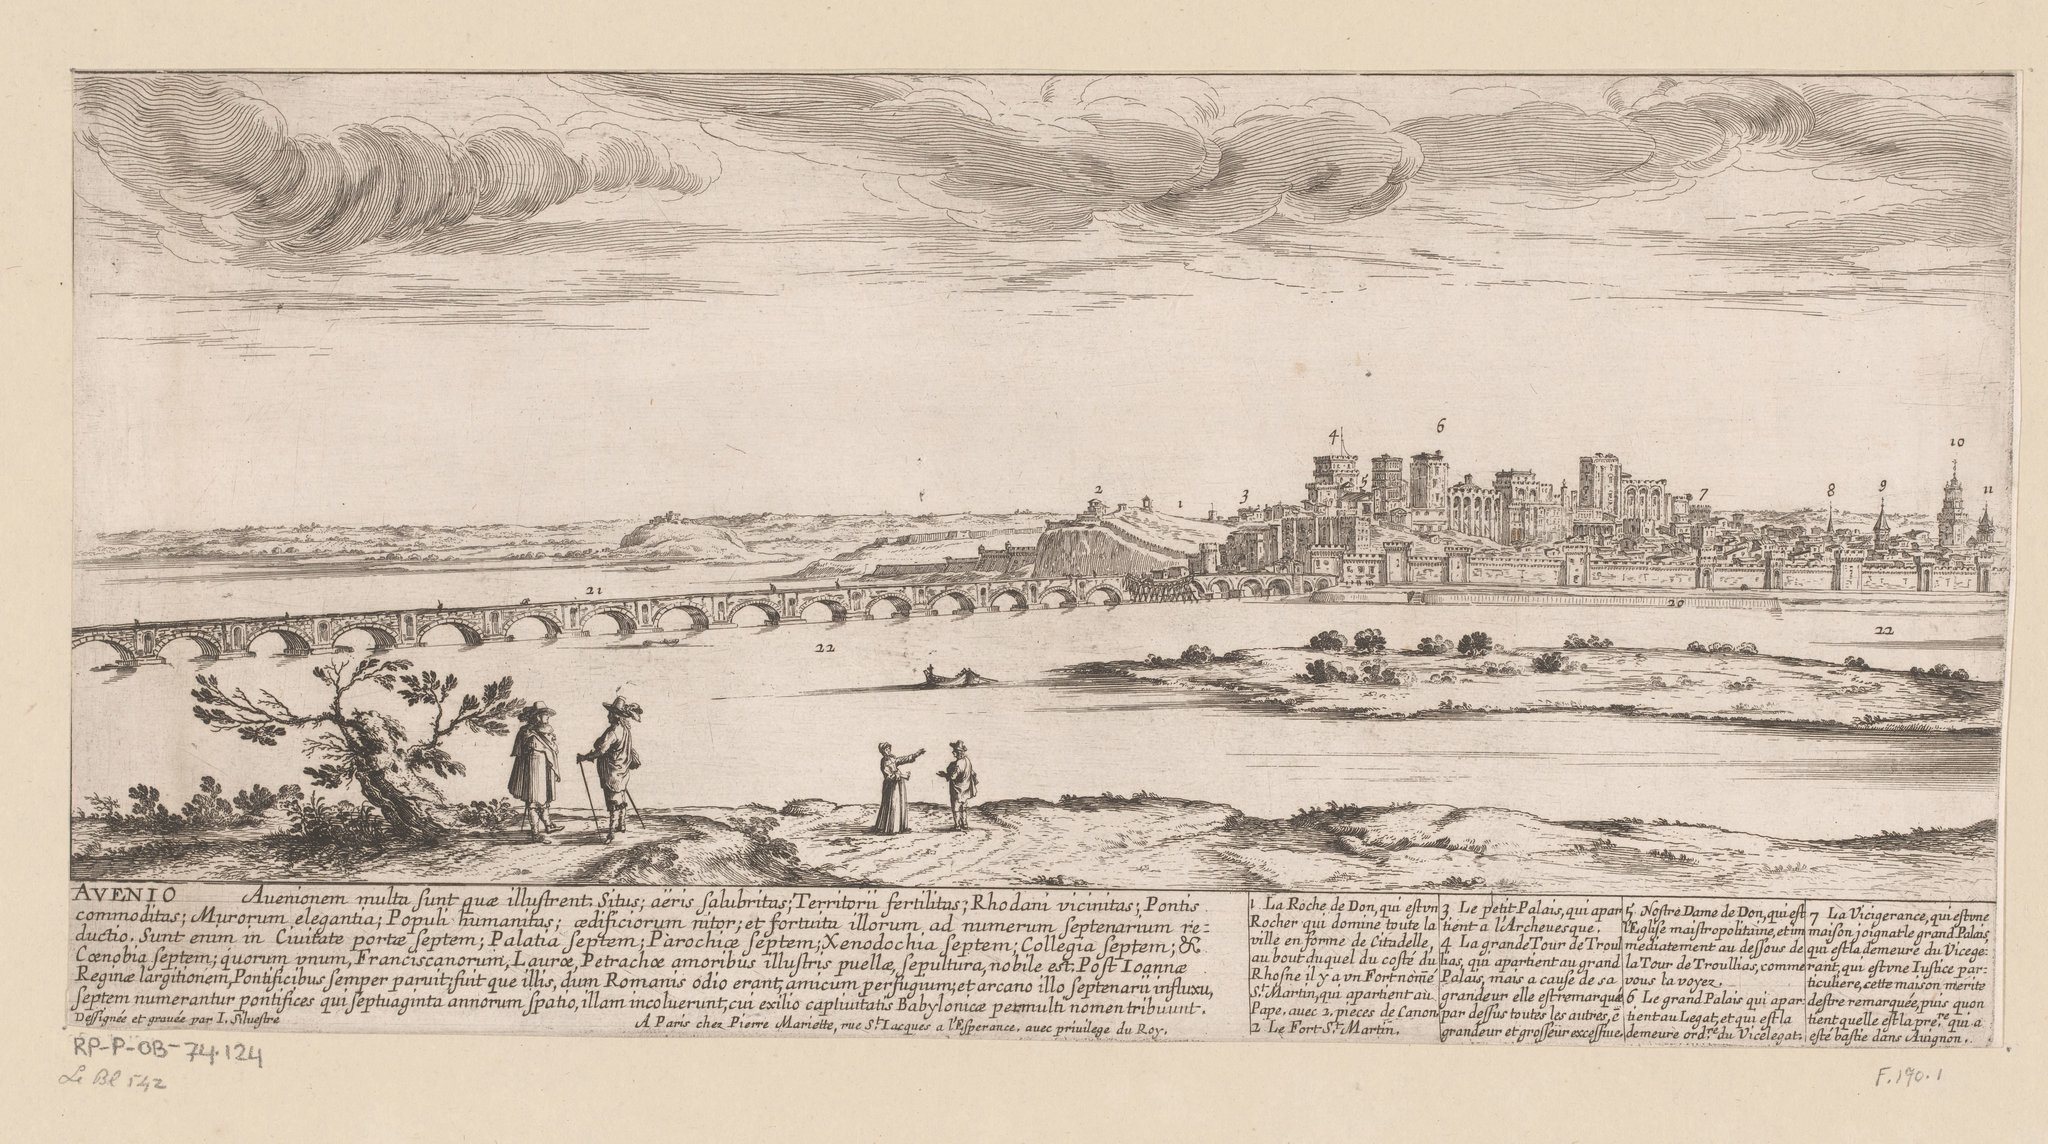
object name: print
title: Gezicht op Avignon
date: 1631-1657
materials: paper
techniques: etching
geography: france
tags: city-view in general; 'veduta'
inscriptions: collector's mark: Lugt 240